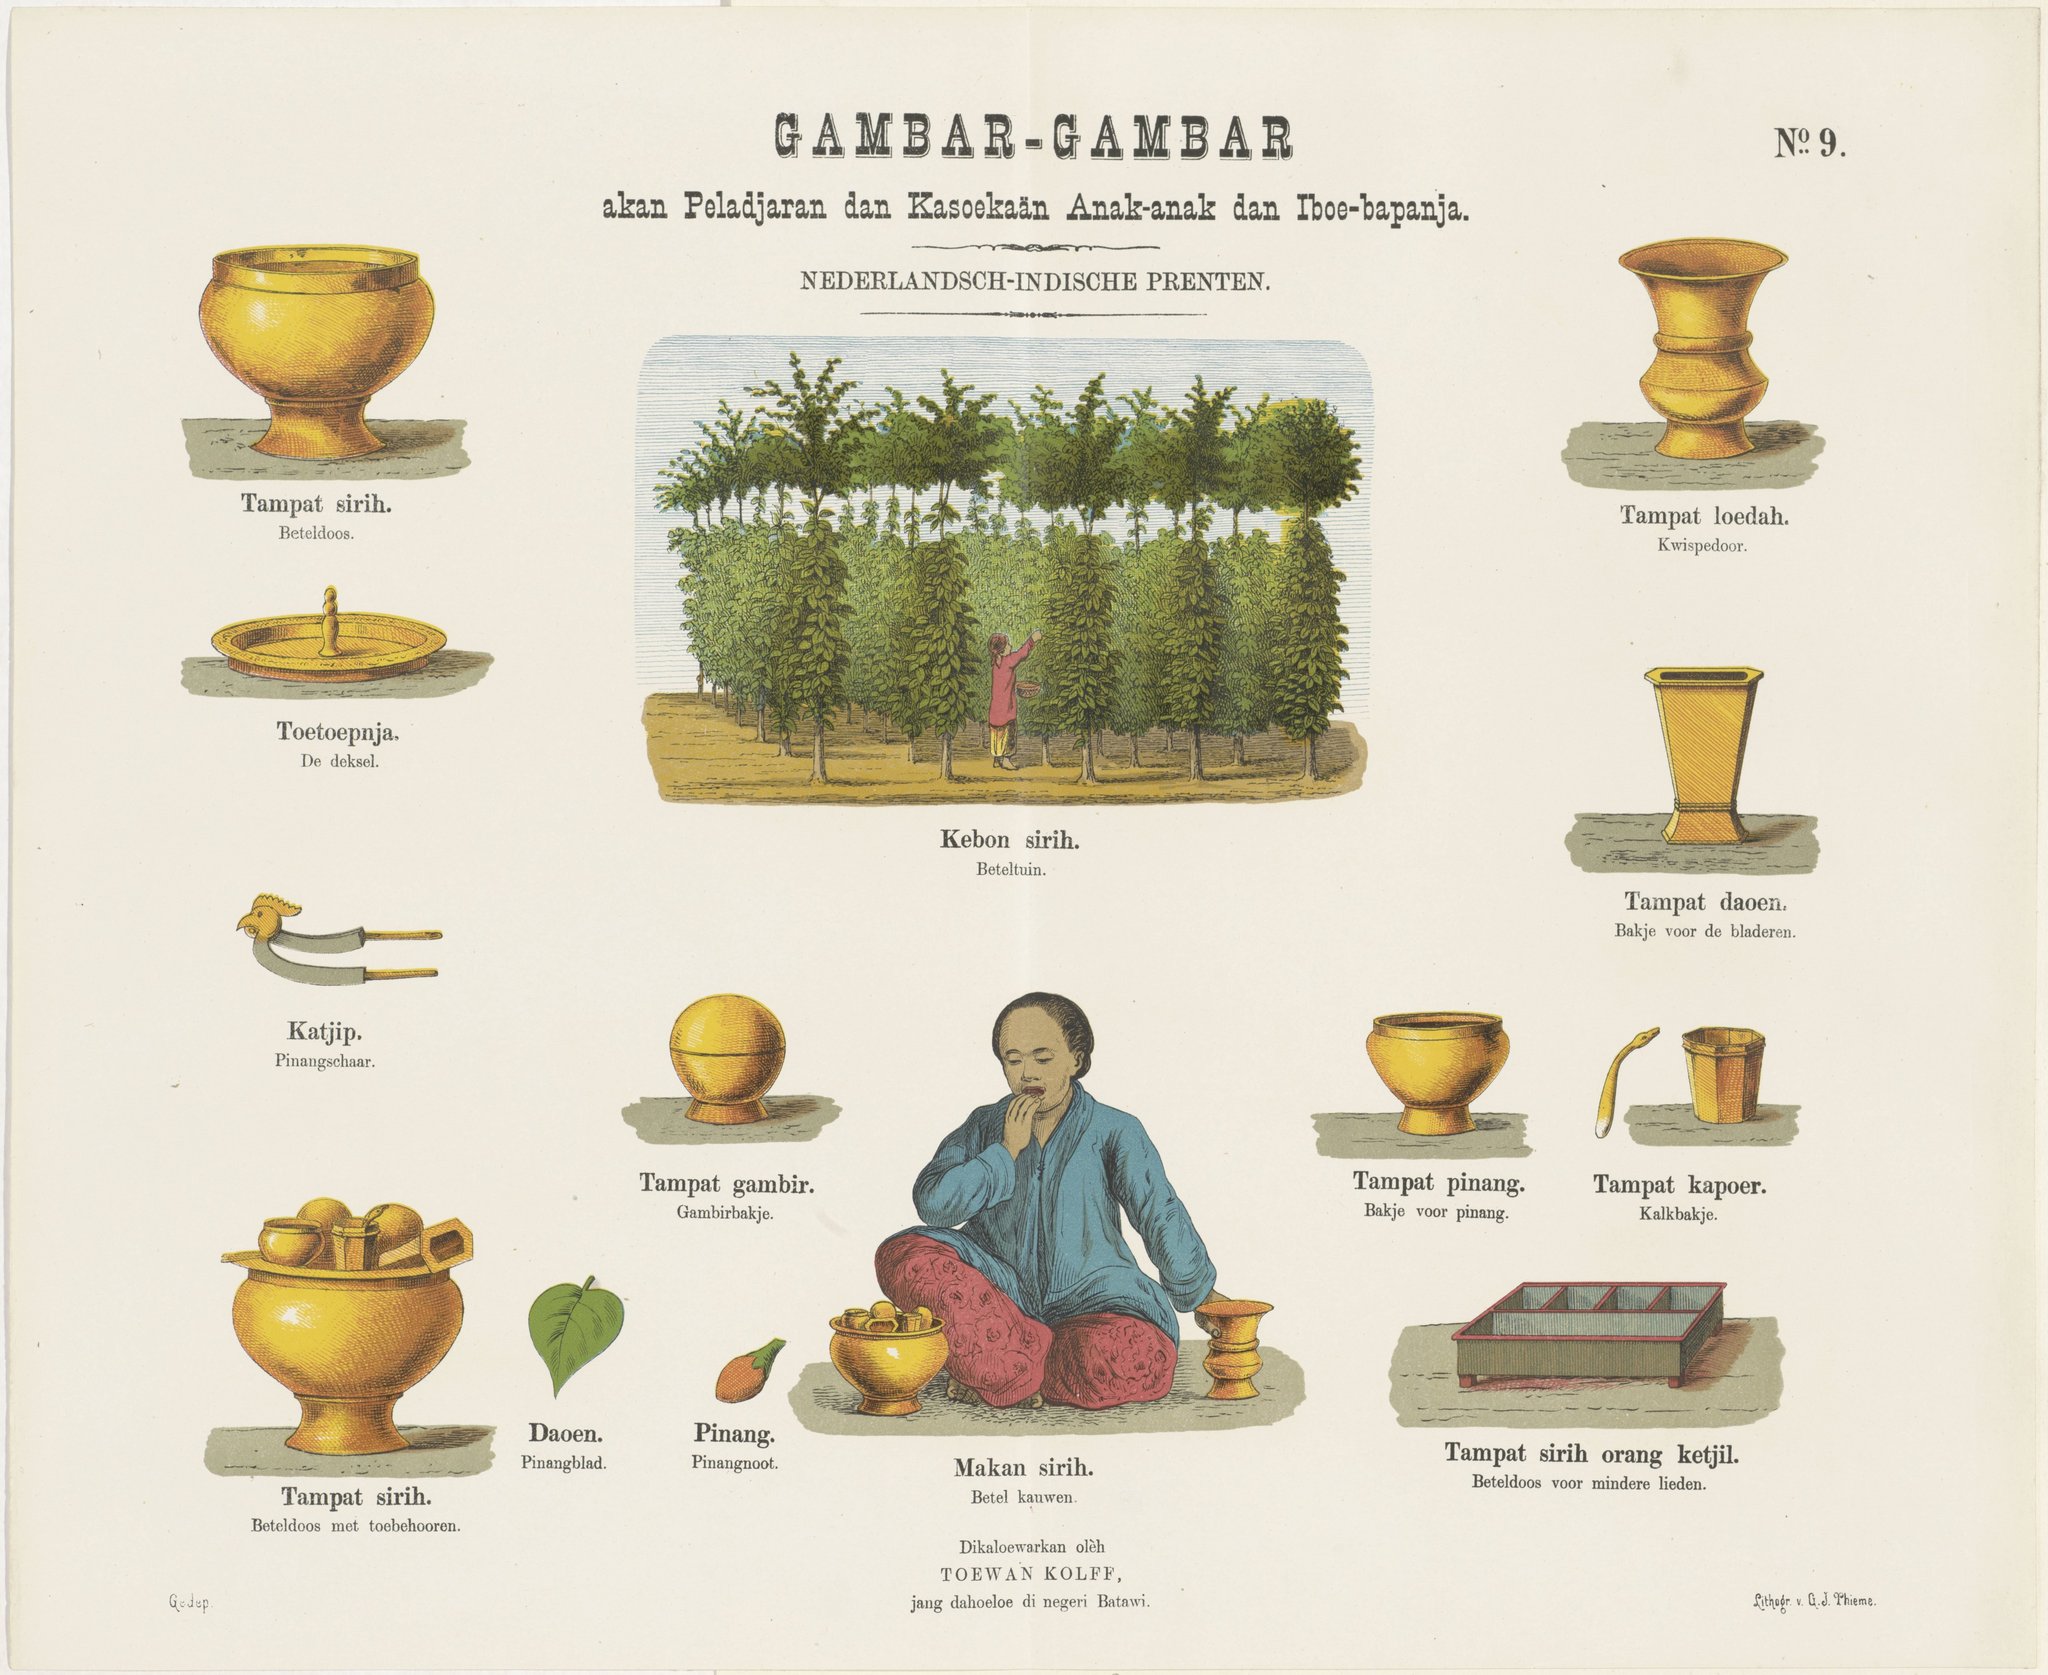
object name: popular print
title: Betel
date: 1868-1881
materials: paper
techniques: lithograph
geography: leiden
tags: asiatic races and peoples, chewing, betel, sirih, dutch east indies, the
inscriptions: collector's mark: Lugt 2760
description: Blad met veertien voorstellingen van een beteltuin, een vrouw die betel kauwt en voorwerpen voor het oogsten, bereiden en bewaren van betel in de voormalige kolonie Nederlands-Indië. Onder elke afbeelding een onderschrift in het Maleis en het Nederlands. Genummerd rechtsboven: No. 9.